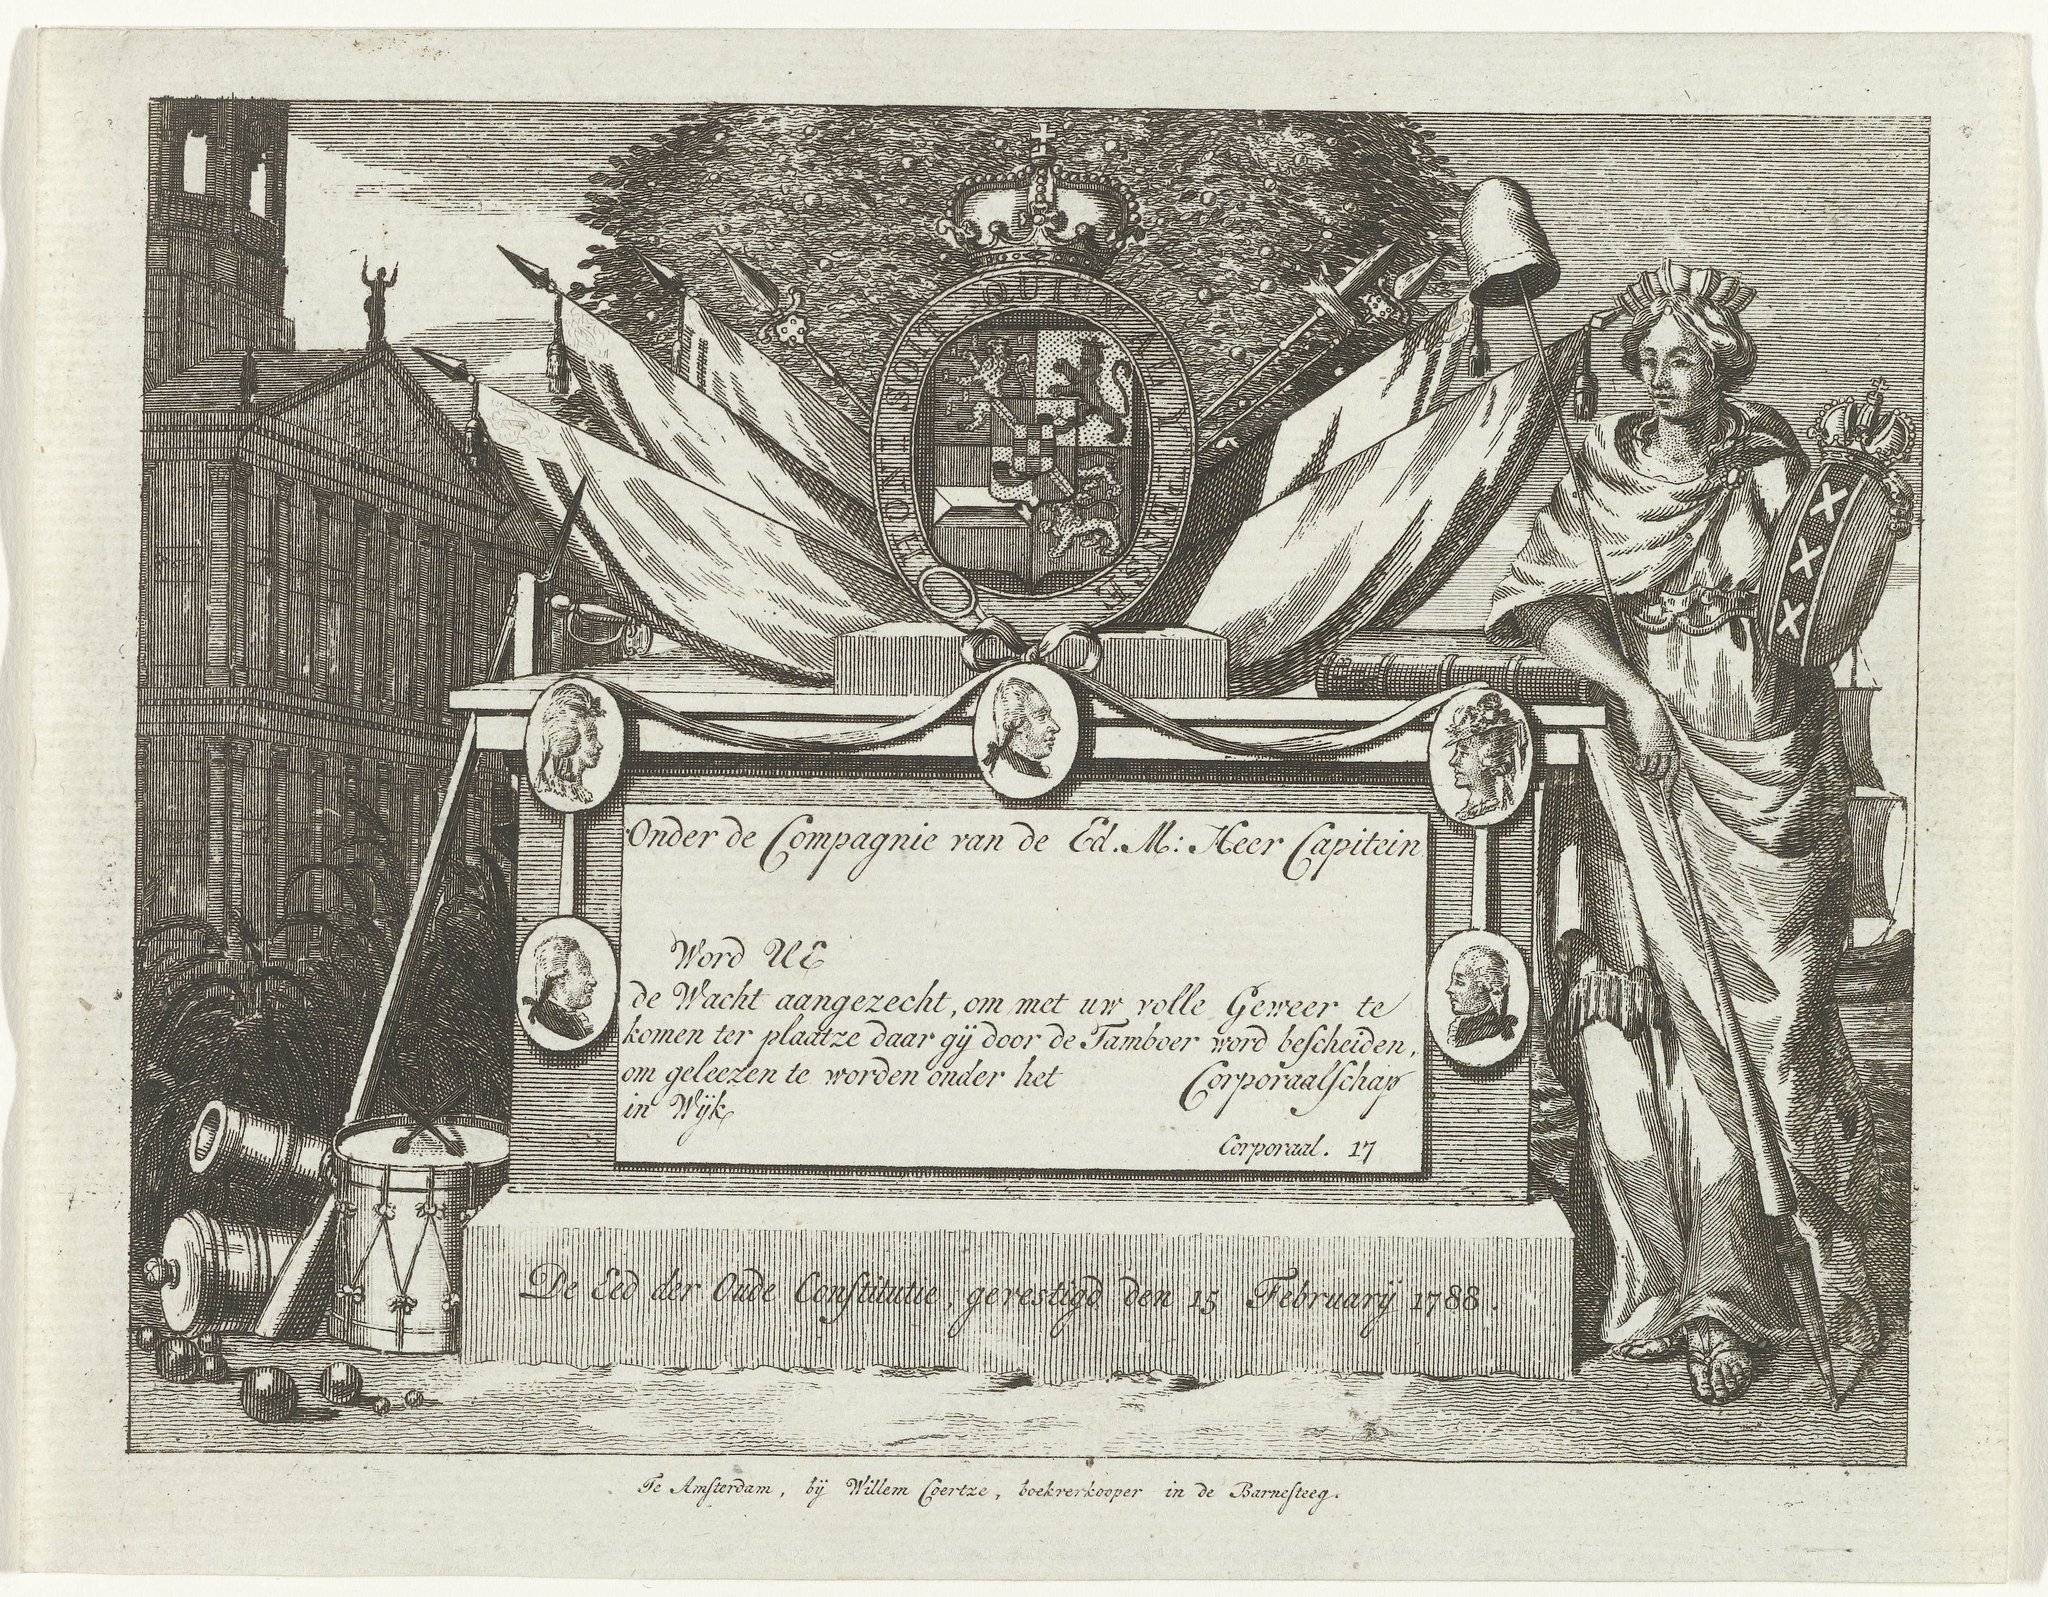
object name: print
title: Schuttersbrief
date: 1788-1789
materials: paper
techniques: engraving, etching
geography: amsterdam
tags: personification of a city, town-patron(ess), amsterdam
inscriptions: collector's mark: Lugt 2228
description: Schuttersbrief, zonder naam, met oproep van de schutterij 'De Eed der Oude Constitutie' (gevestigd 15 februari 1788) te Amsterdam. Voorgedrukte brief versierd met het wapen van de prins voor een Oranjeboom, vaandels en de stadmaagd van Amsterdam. Links het stadhuis op de Dam.